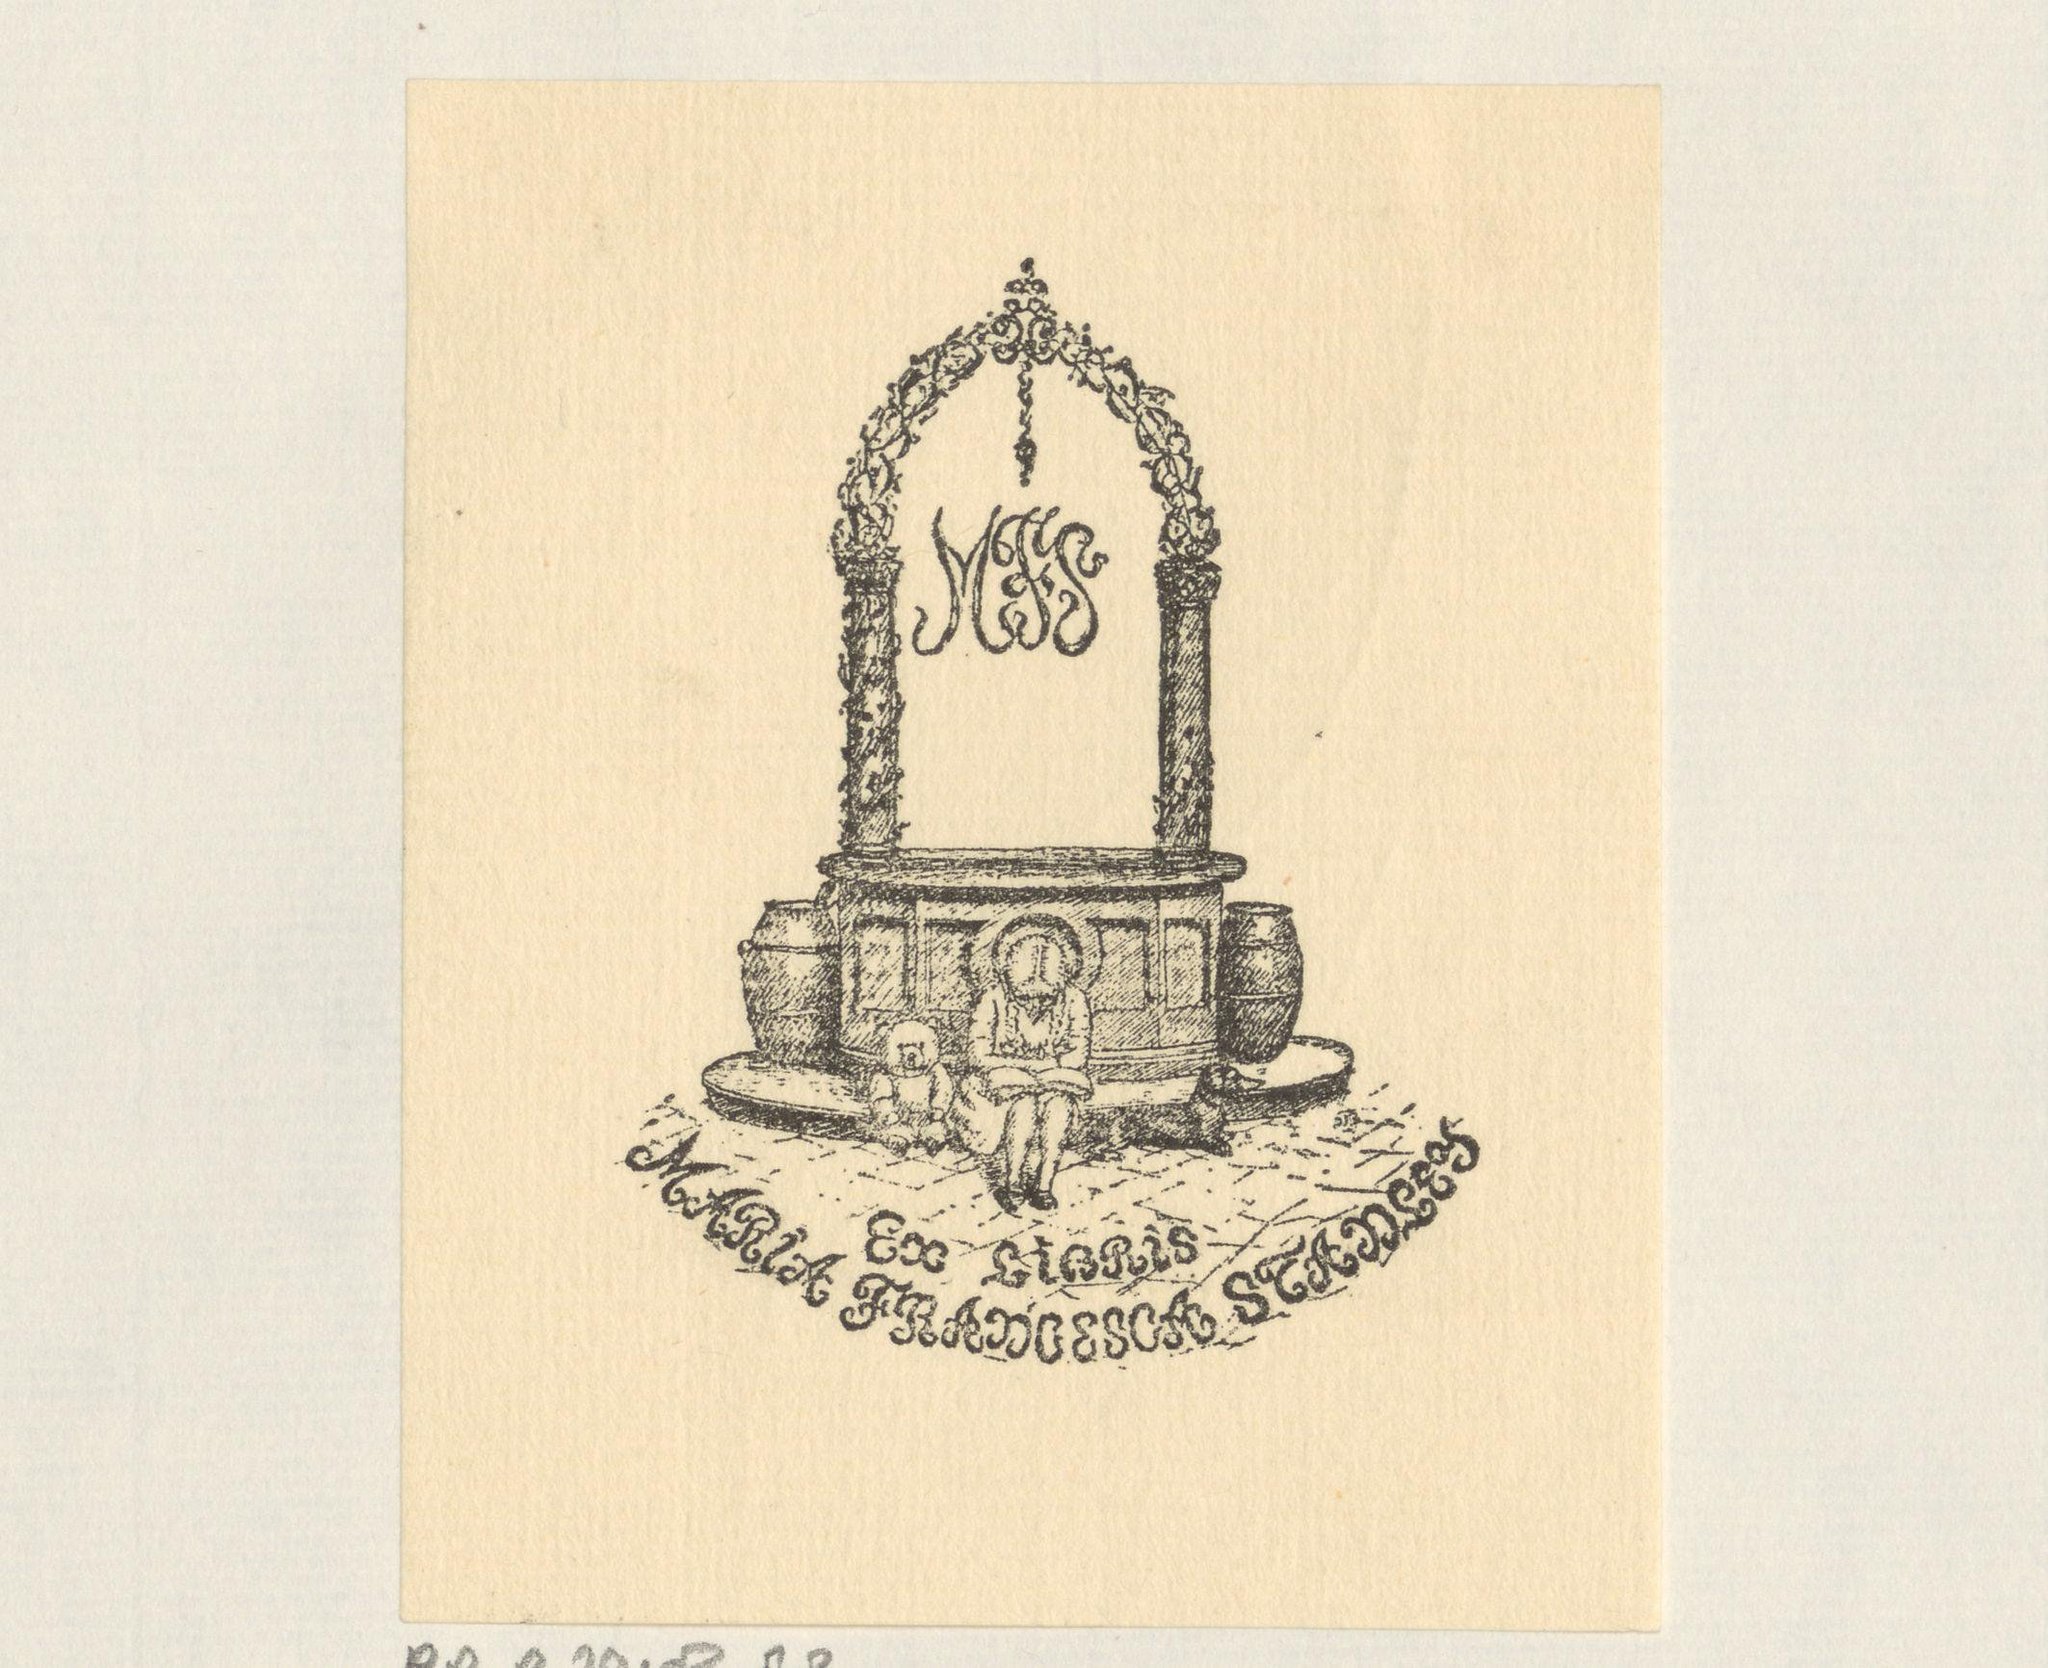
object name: bookplate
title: Ex libris van Maria Francesca Stanley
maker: Anonymous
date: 1880-1999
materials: paper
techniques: printing block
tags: well, reading, sitting figure - aa - female human figure, dog